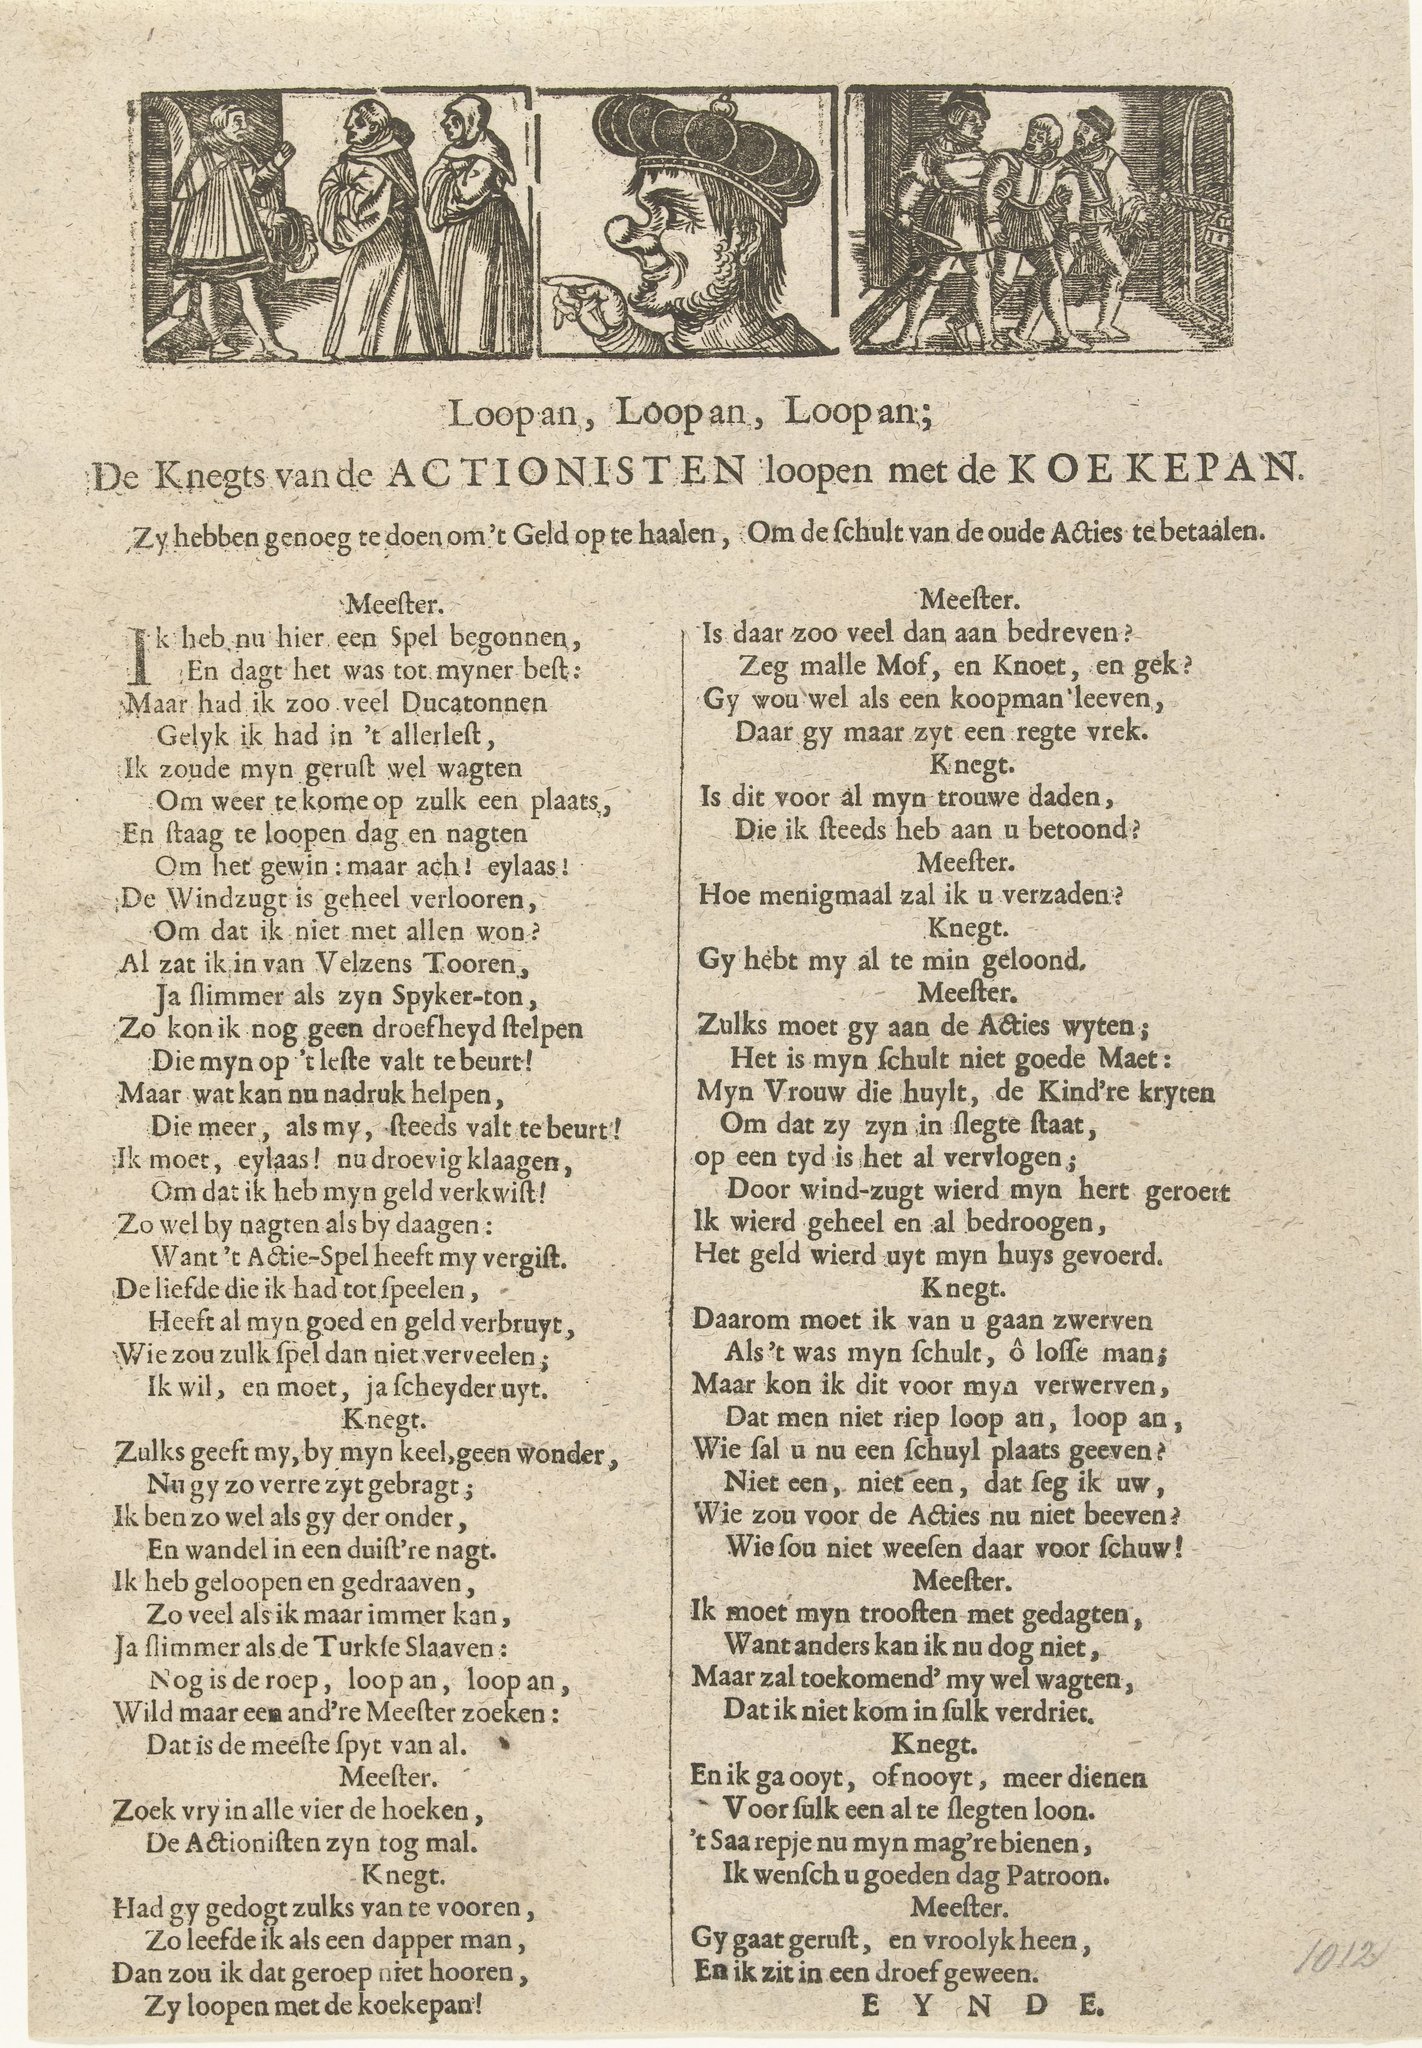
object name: cartoon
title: Het Groote Tafereel der Dwaasheid (extra stukken)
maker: Anonymous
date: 1720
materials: paper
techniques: letterpress printing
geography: northern netherlands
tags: arrest (of criminal)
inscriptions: collector's mark: Lugt 2228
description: Blad met een spotvers over de knechten van de actionisten die voor hun berooide bazen geld moeten bedelen. Bovenaan drie voorstellingen van twee monniken bij een edelman, een dwaas met muts en grote neus en de arrestatie van een man door twee wetsdienaren. Met een vers in twee kolommen waarin een samenspraak tussen de Meester en de Knegt. Behoort tot de groep van bijprenten toegevoegd aan de serie Tafereel der Dwaasheid met spotprenten op de Windhandel of Actiehandel van 1720.